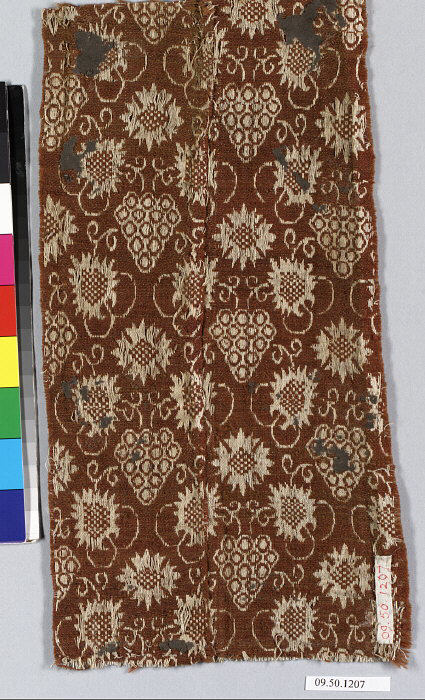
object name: fragment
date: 1501-1600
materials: linen, wool